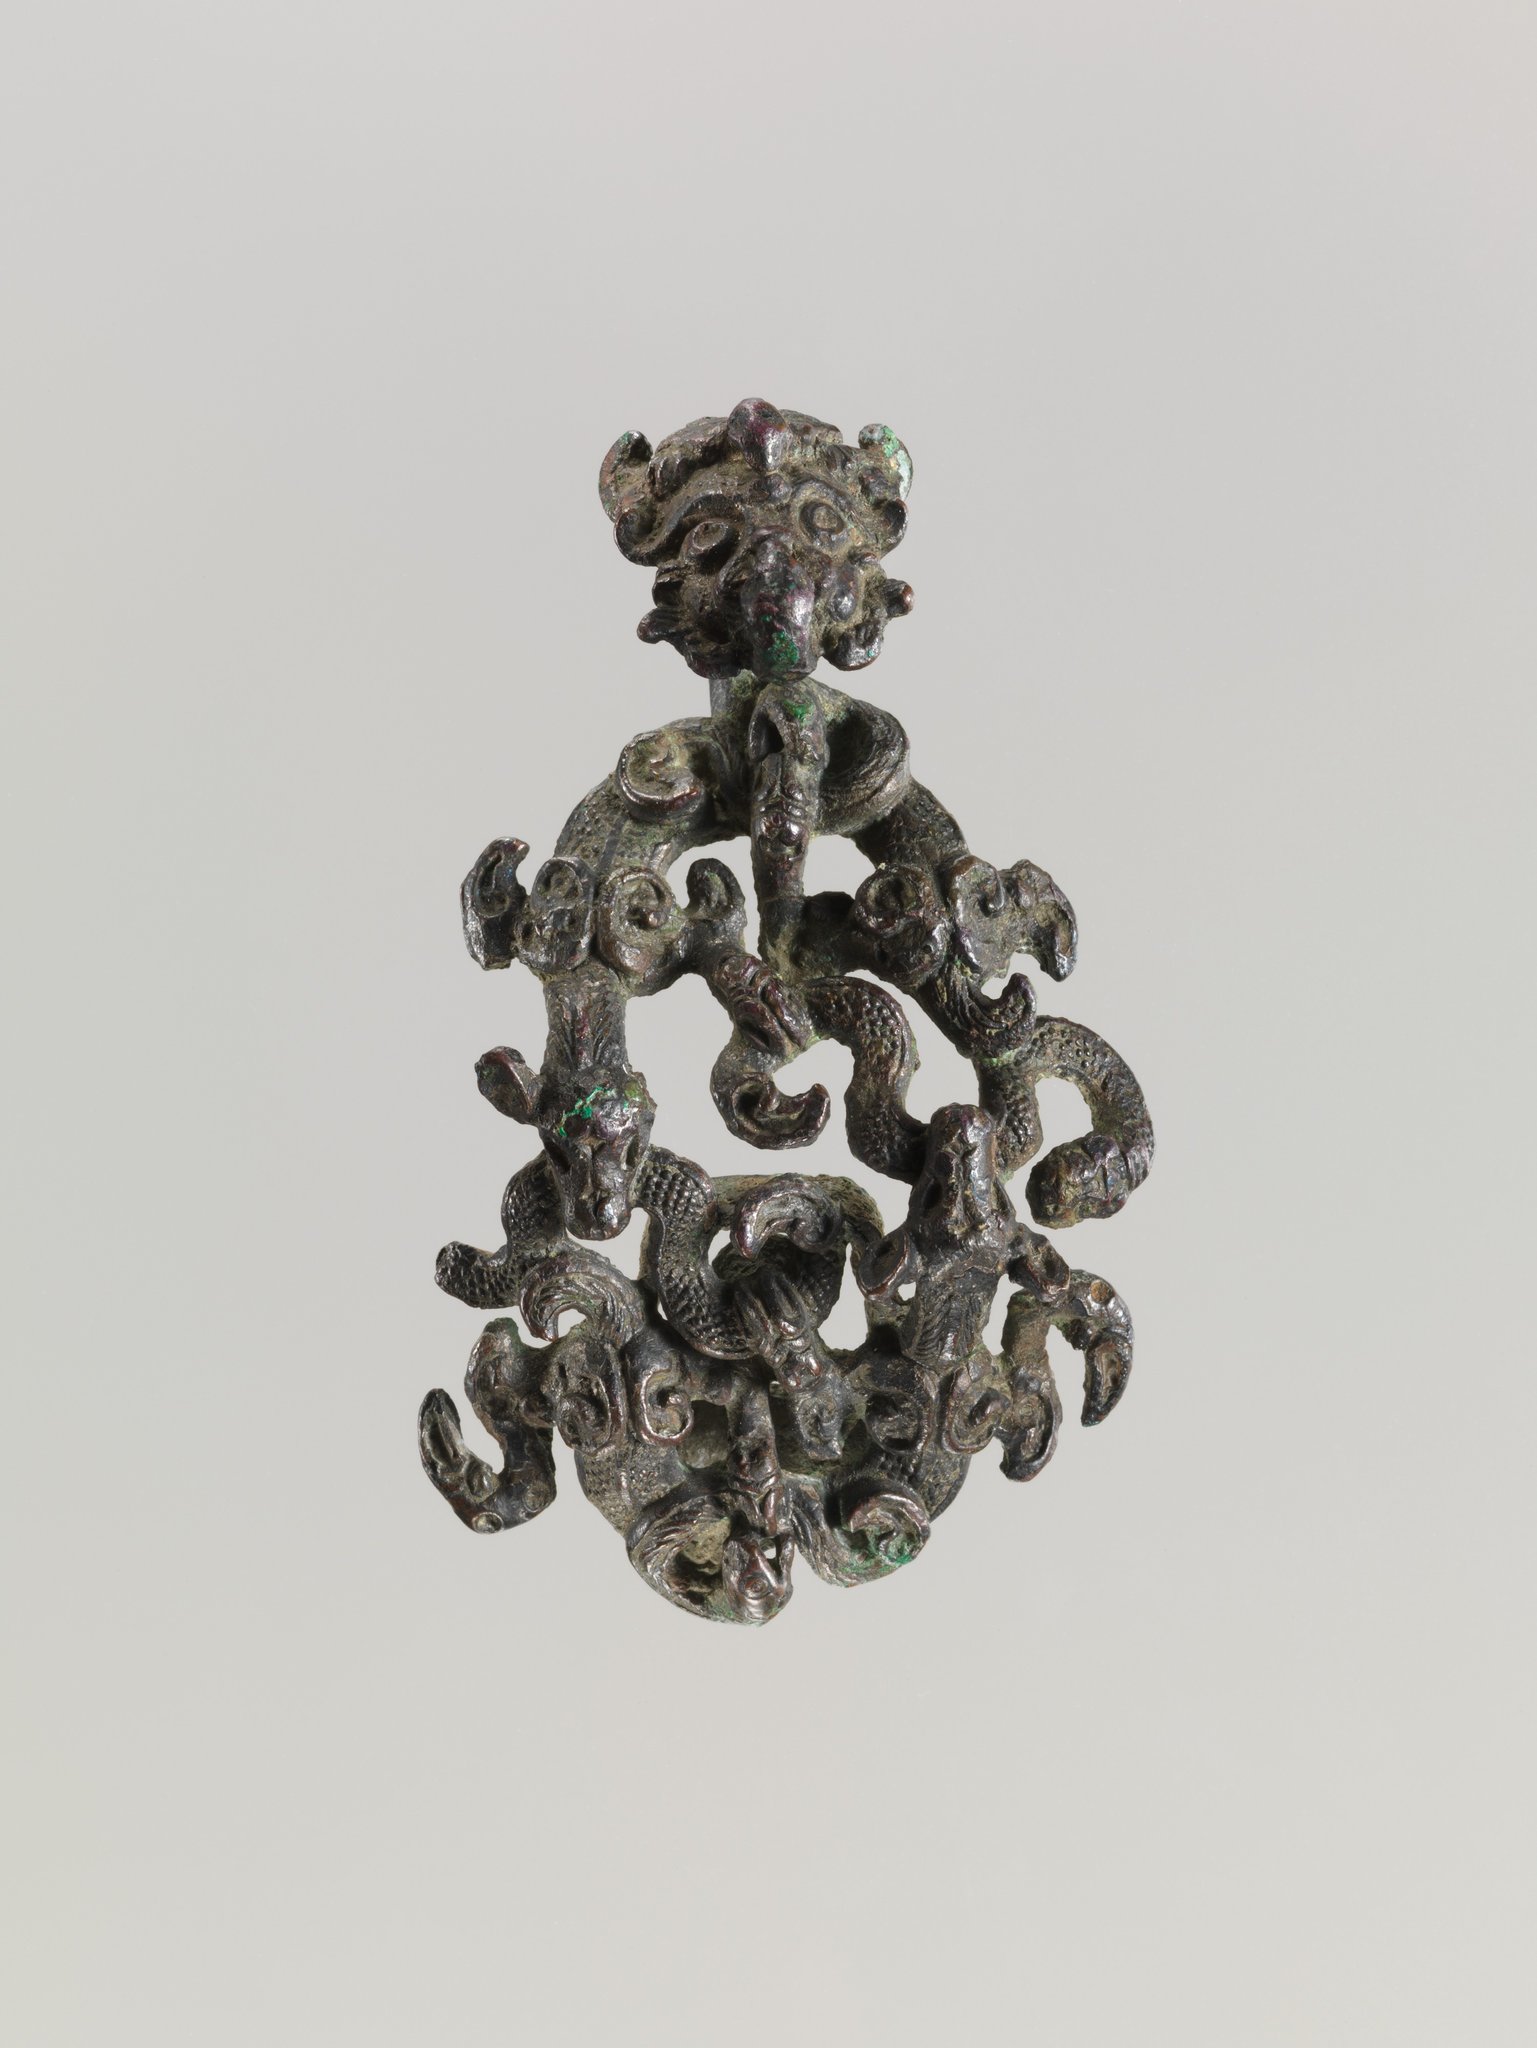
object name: belt hook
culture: chinese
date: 500-201 BCE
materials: bronze